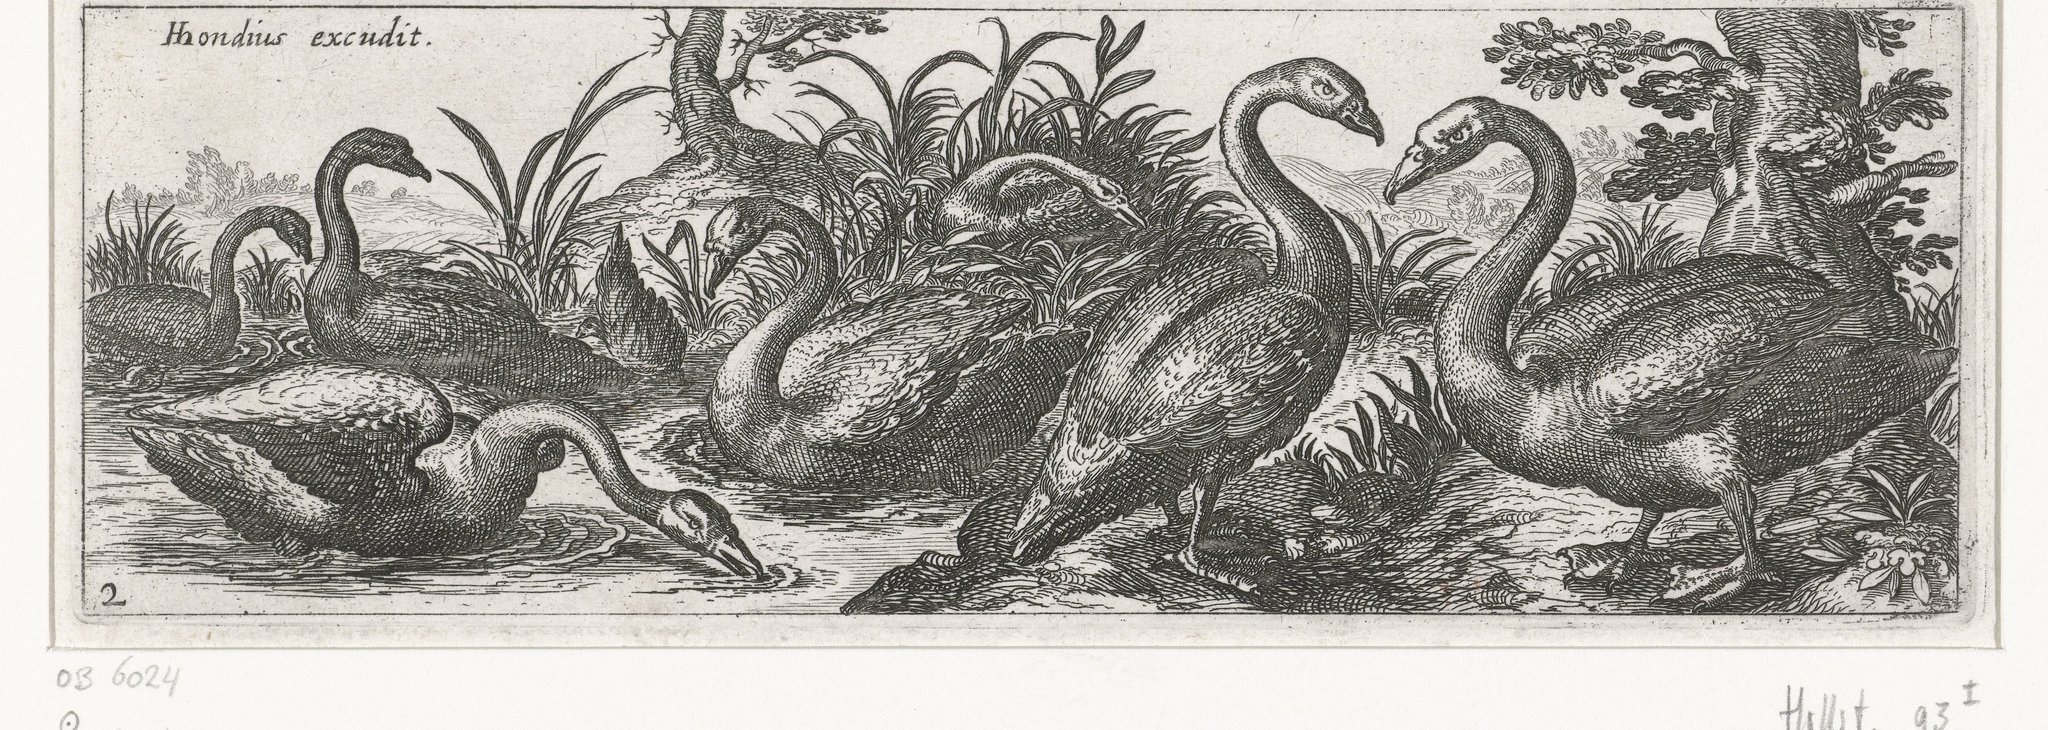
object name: print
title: Zwanen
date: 1609-1610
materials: paper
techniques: engraving, etching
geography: northern netherlands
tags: water-birds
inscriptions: collector's mark: Lugt 240